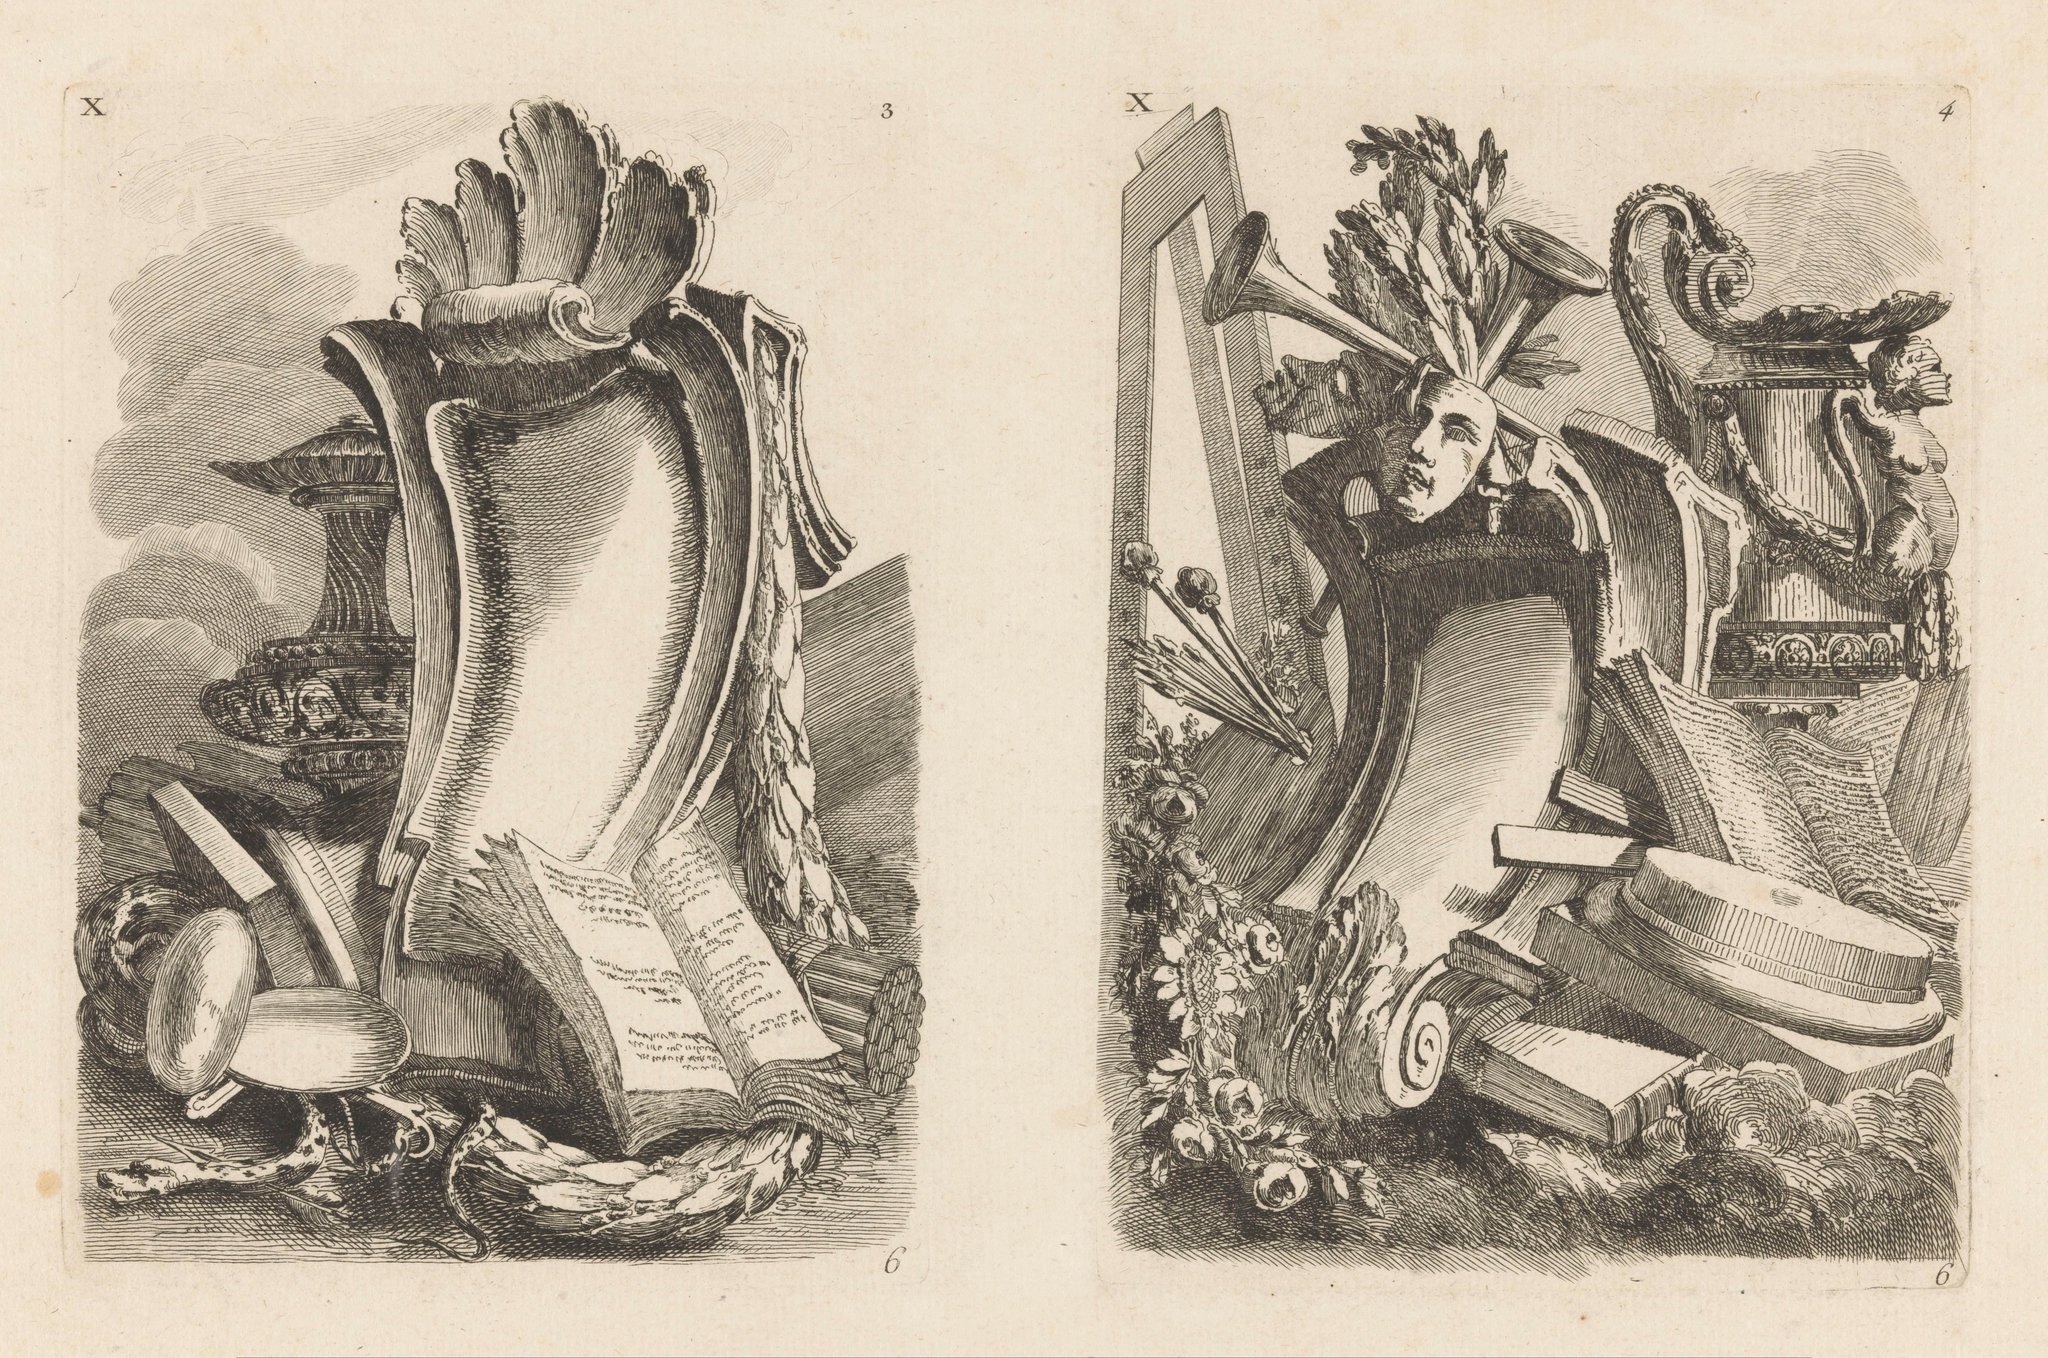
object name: ornament print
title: X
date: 1771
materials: paper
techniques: engraving, etching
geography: paris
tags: book, ornament ~ cartouche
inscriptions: collector's mark: Lugt 2228, collector's mark: Lugt 2760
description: Twee cartouches op een blad. Links met een boek, een vaas , een gevallen zuil en een slang. Rechts met een vaas, een boek, een basement, een palet met kwasten, een schildersezel, maskers en bazuinen. Rechts onder 6 genummerd.